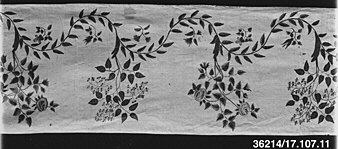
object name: strip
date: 1701-1800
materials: silk